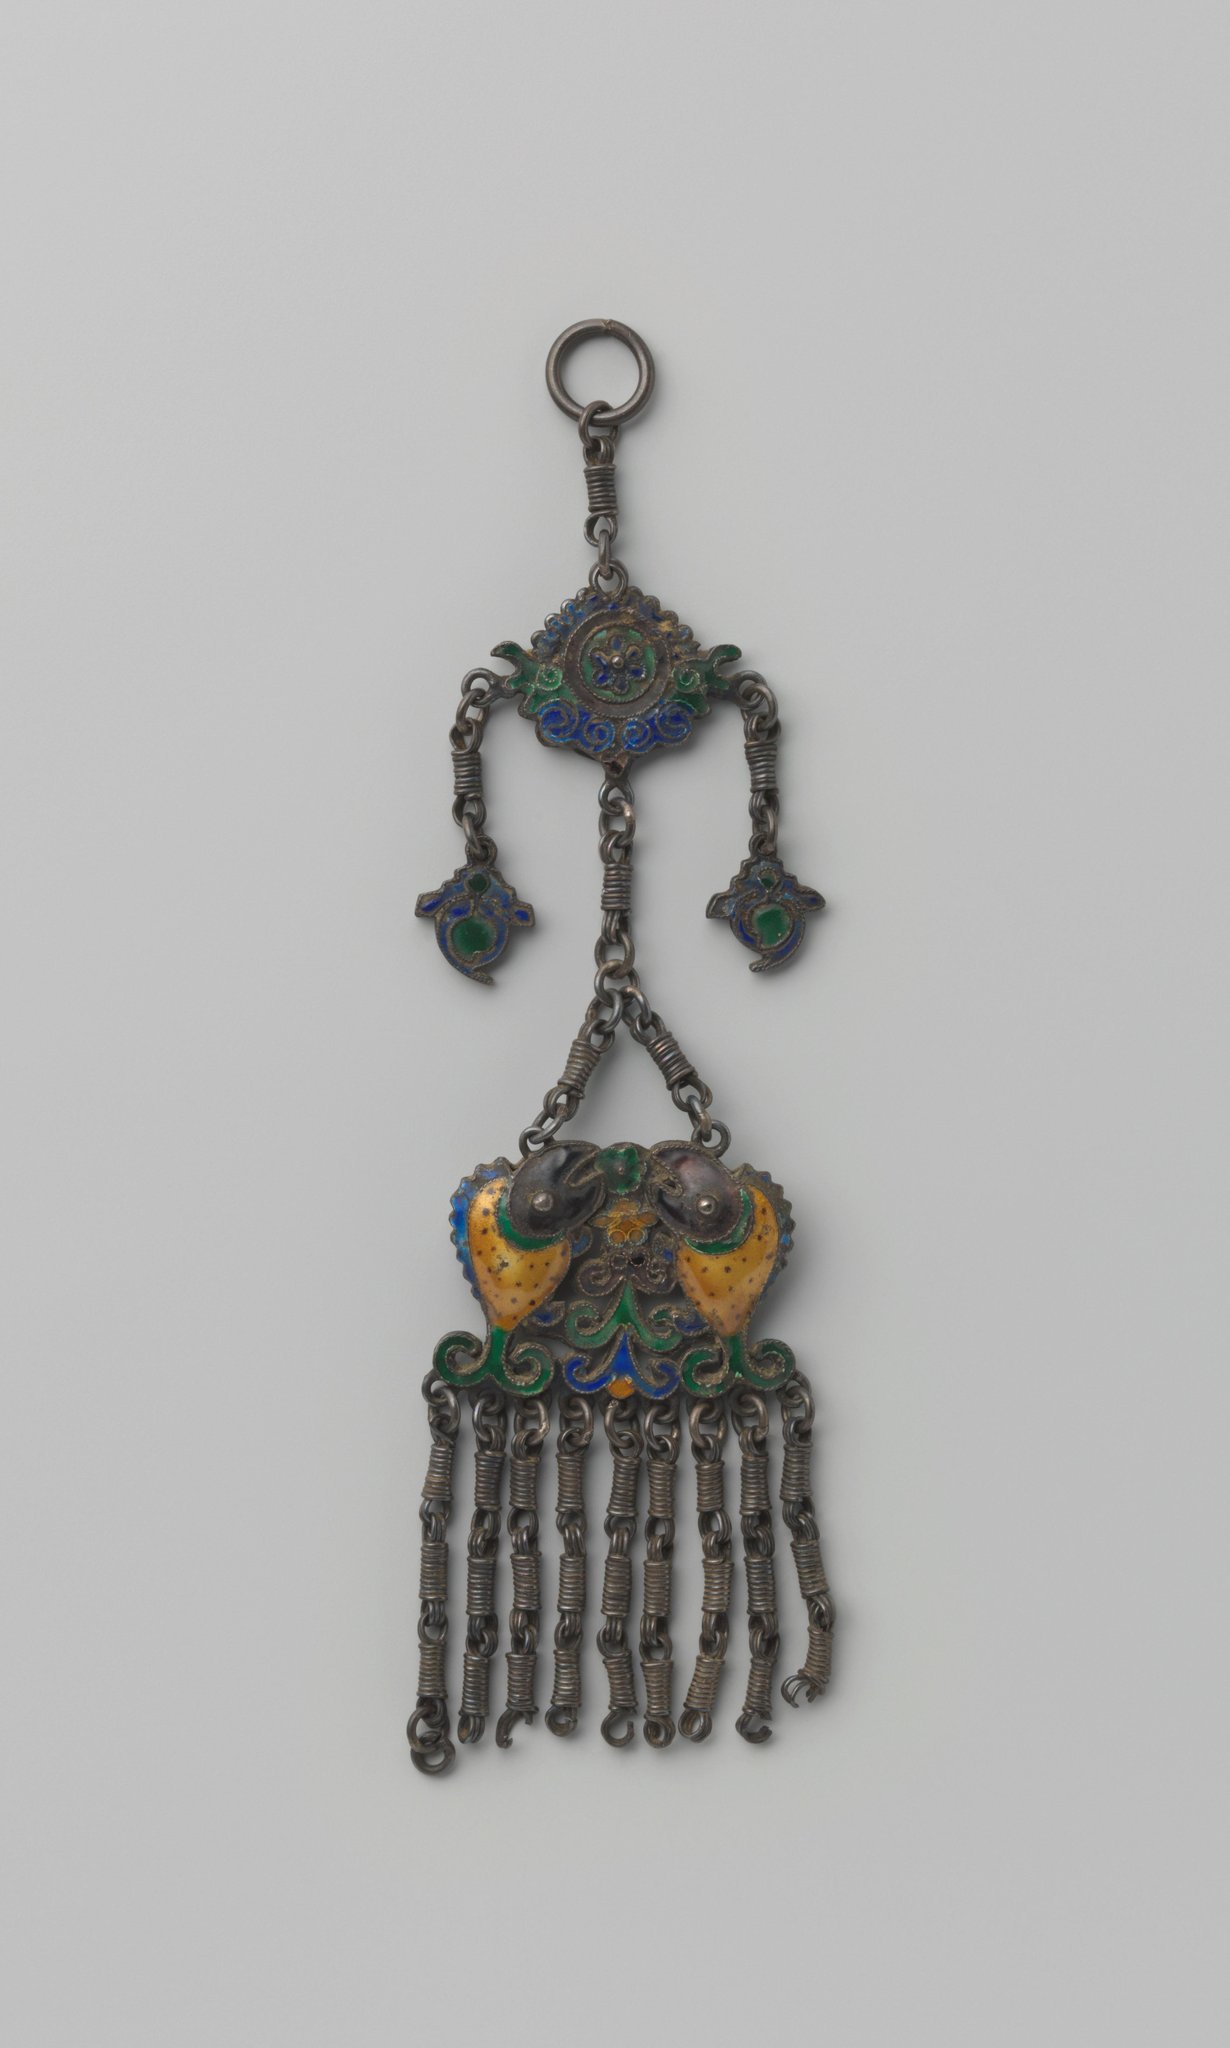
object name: jewellery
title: Chatelaine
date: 1600-1699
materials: silver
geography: iran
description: Chatelaine van zilver met email. Het lichaam bestaat uit 2 vissen, hieronder hangen 9 kettinkjes.